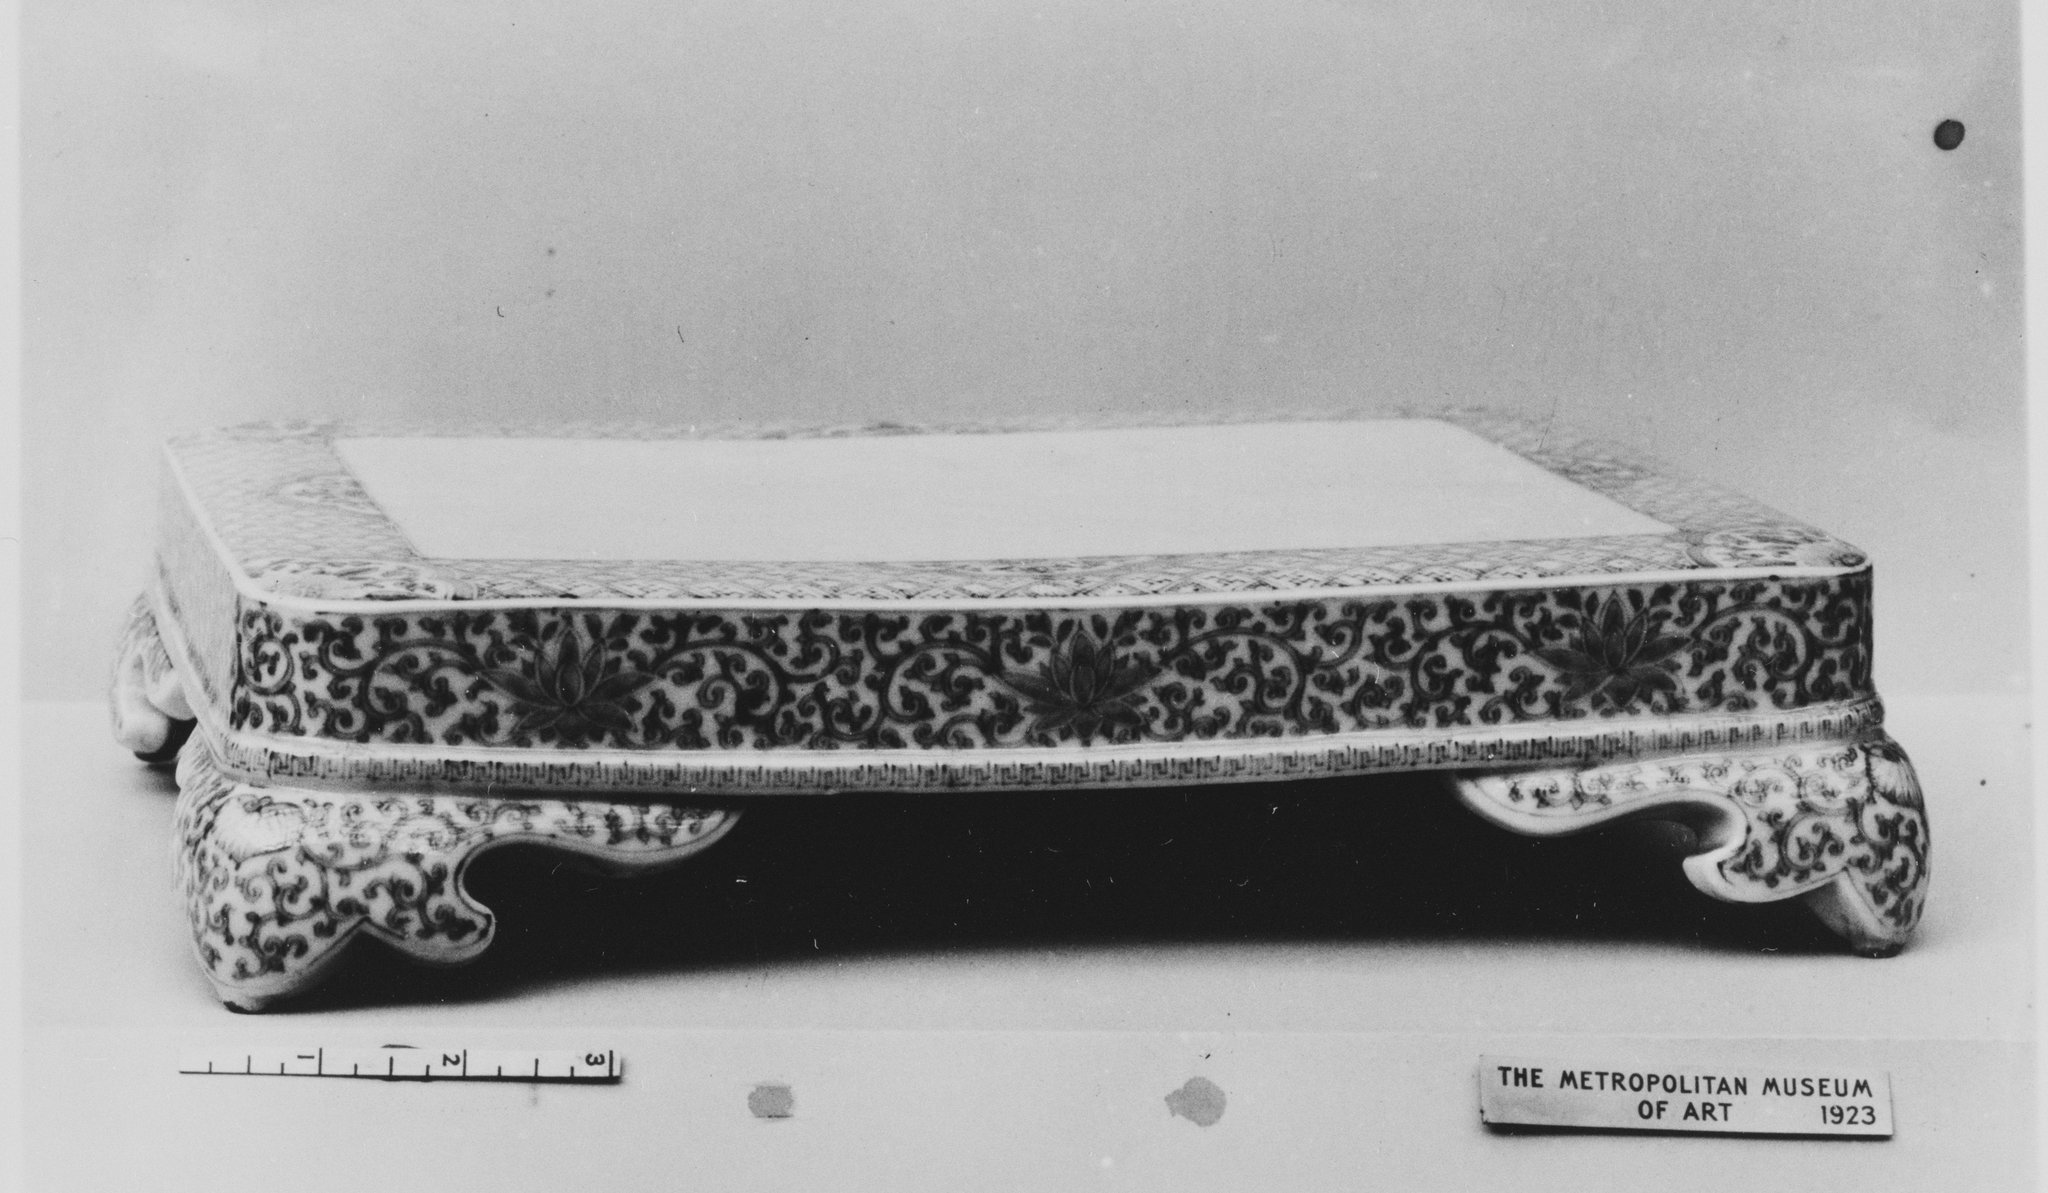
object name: stand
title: Stand for Alcove Ornament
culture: japanese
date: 1840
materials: glaze, porcelain